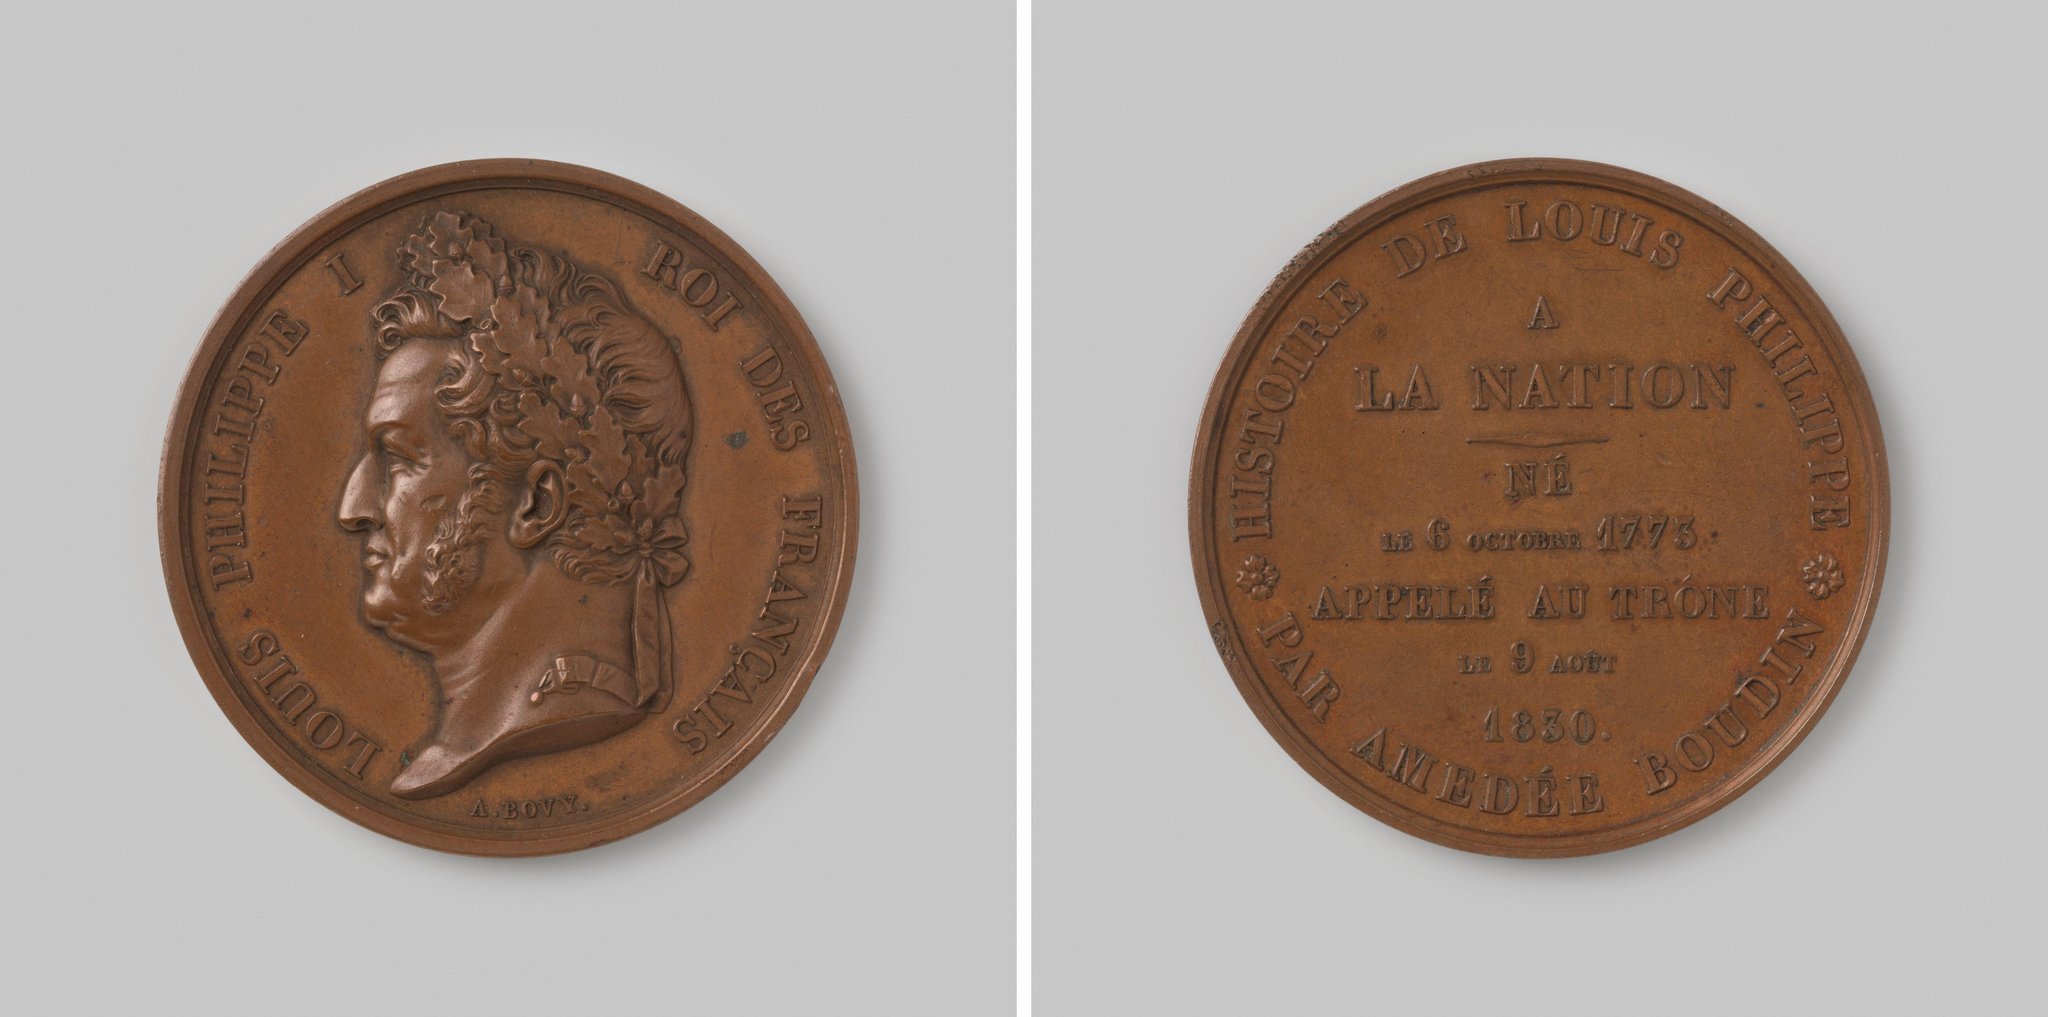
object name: history medal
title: Uitgifte van de Histoire de Louis-Philippe 1830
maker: jean françois antoine bovy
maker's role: medailleur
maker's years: 1795-1877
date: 1830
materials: copper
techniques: striking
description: Bronzen penning, op de voorzijde het portret van Louis-Philippe naar links met omschrift, op de keerzijde zeven regels tekst met omschrift.